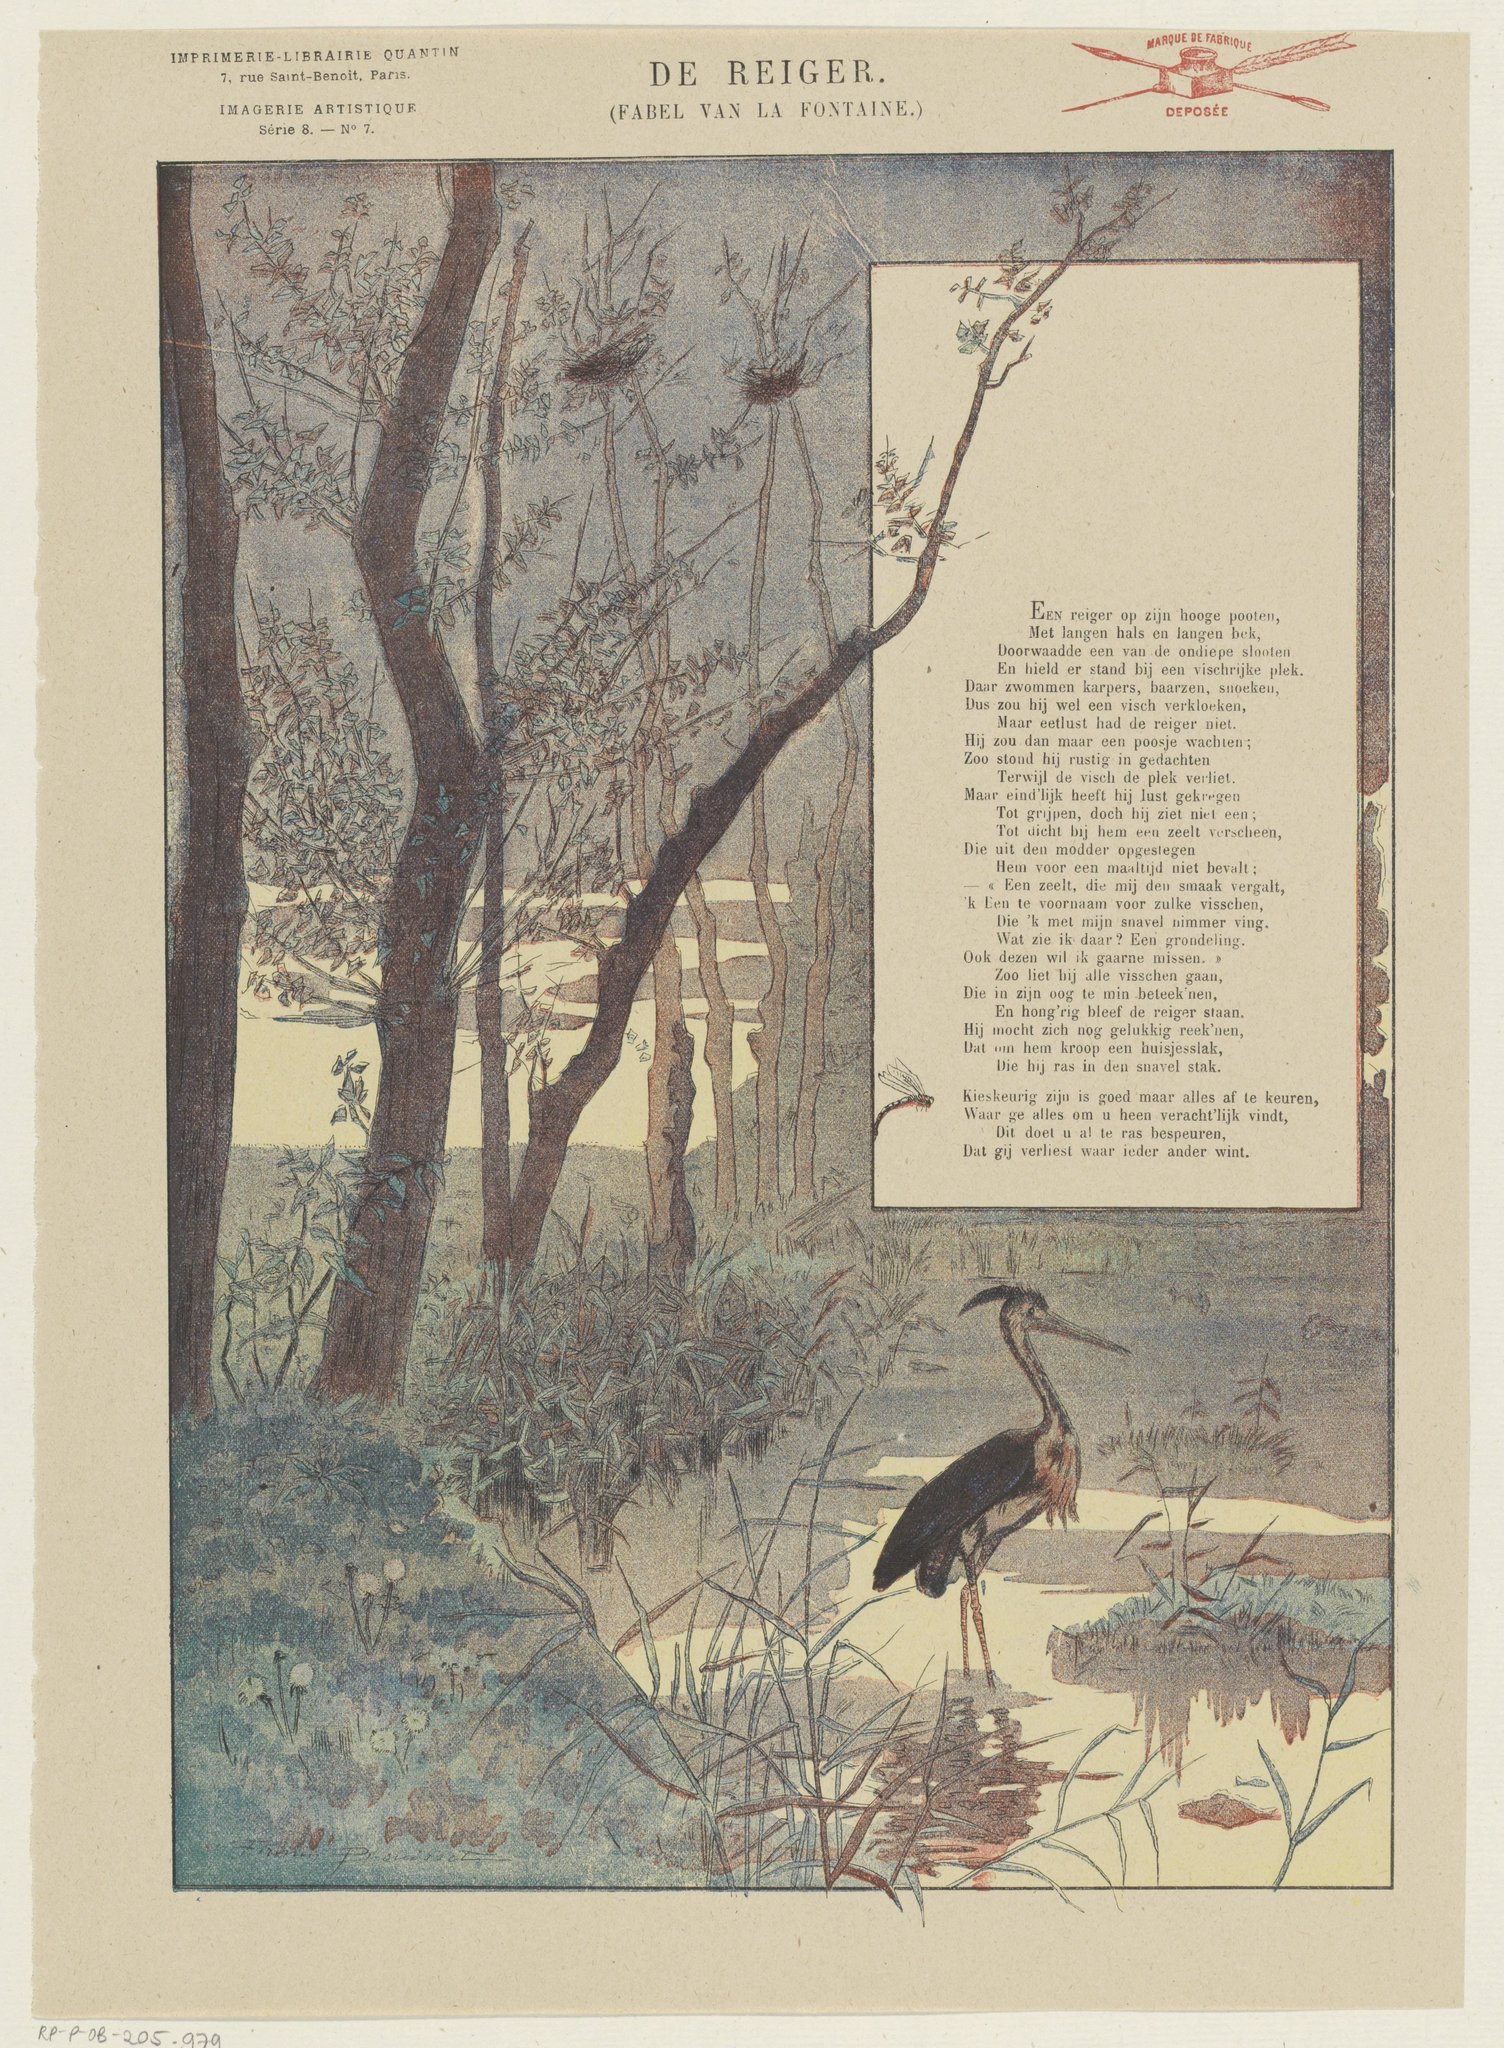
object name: popular print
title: De reiger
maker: albert quantin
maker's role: printer, publisher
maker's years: 1850-1933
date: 1876-1890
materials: paper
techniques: lithograph, letterpress printing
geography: paris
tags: shore-birds and wading-birds: heron, fables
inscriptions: collector's mark: Lugt 2760, : ‘marque de fabrique / deposée’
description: Blad met een grote voorstelling uit de fabel van Jean de La Fontaine, van de reiger. Een reiger in een landschap. Rechtsboven een tekstblok met versregels. Genummerd linksboven: Série 8. - No. 7.